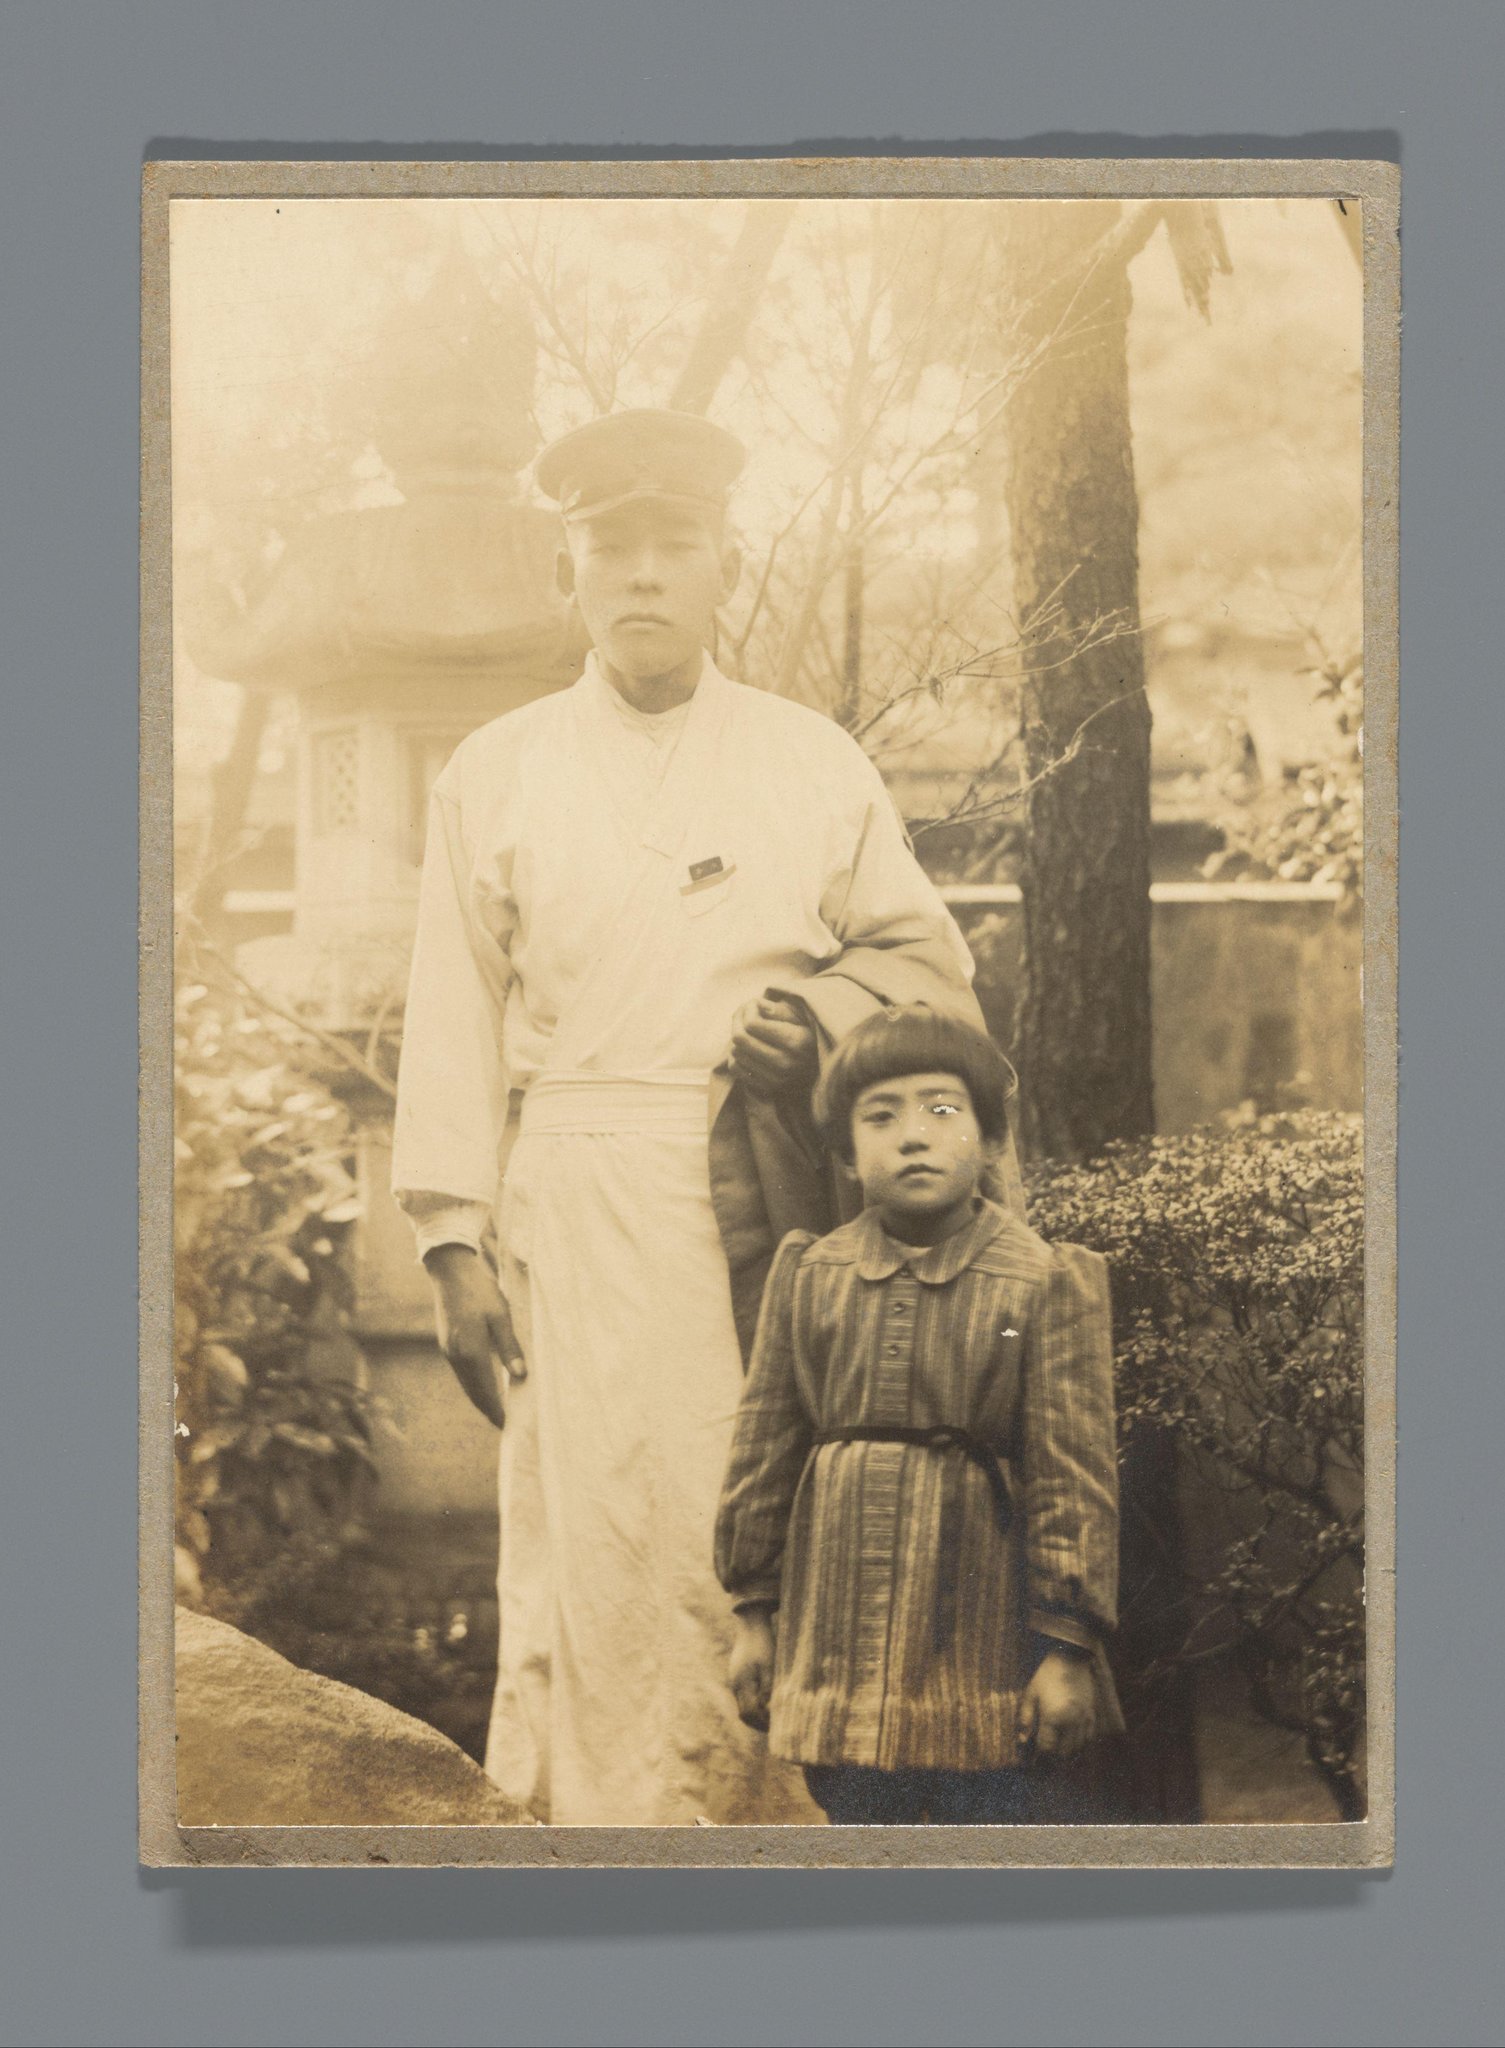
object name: photograph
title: Portret met meisje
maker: Anonymous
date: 1930-1940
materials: photographic support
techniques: gelatin silver print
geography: japan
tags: girl (child between toddler and youth), anonymous historical person portrayed, military training, japan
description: Portret van een Japanse militair staande met een jong meisje. Losse foto in het leporello fotoalbum met foto’s van de diensttijd van Japanse militairen.